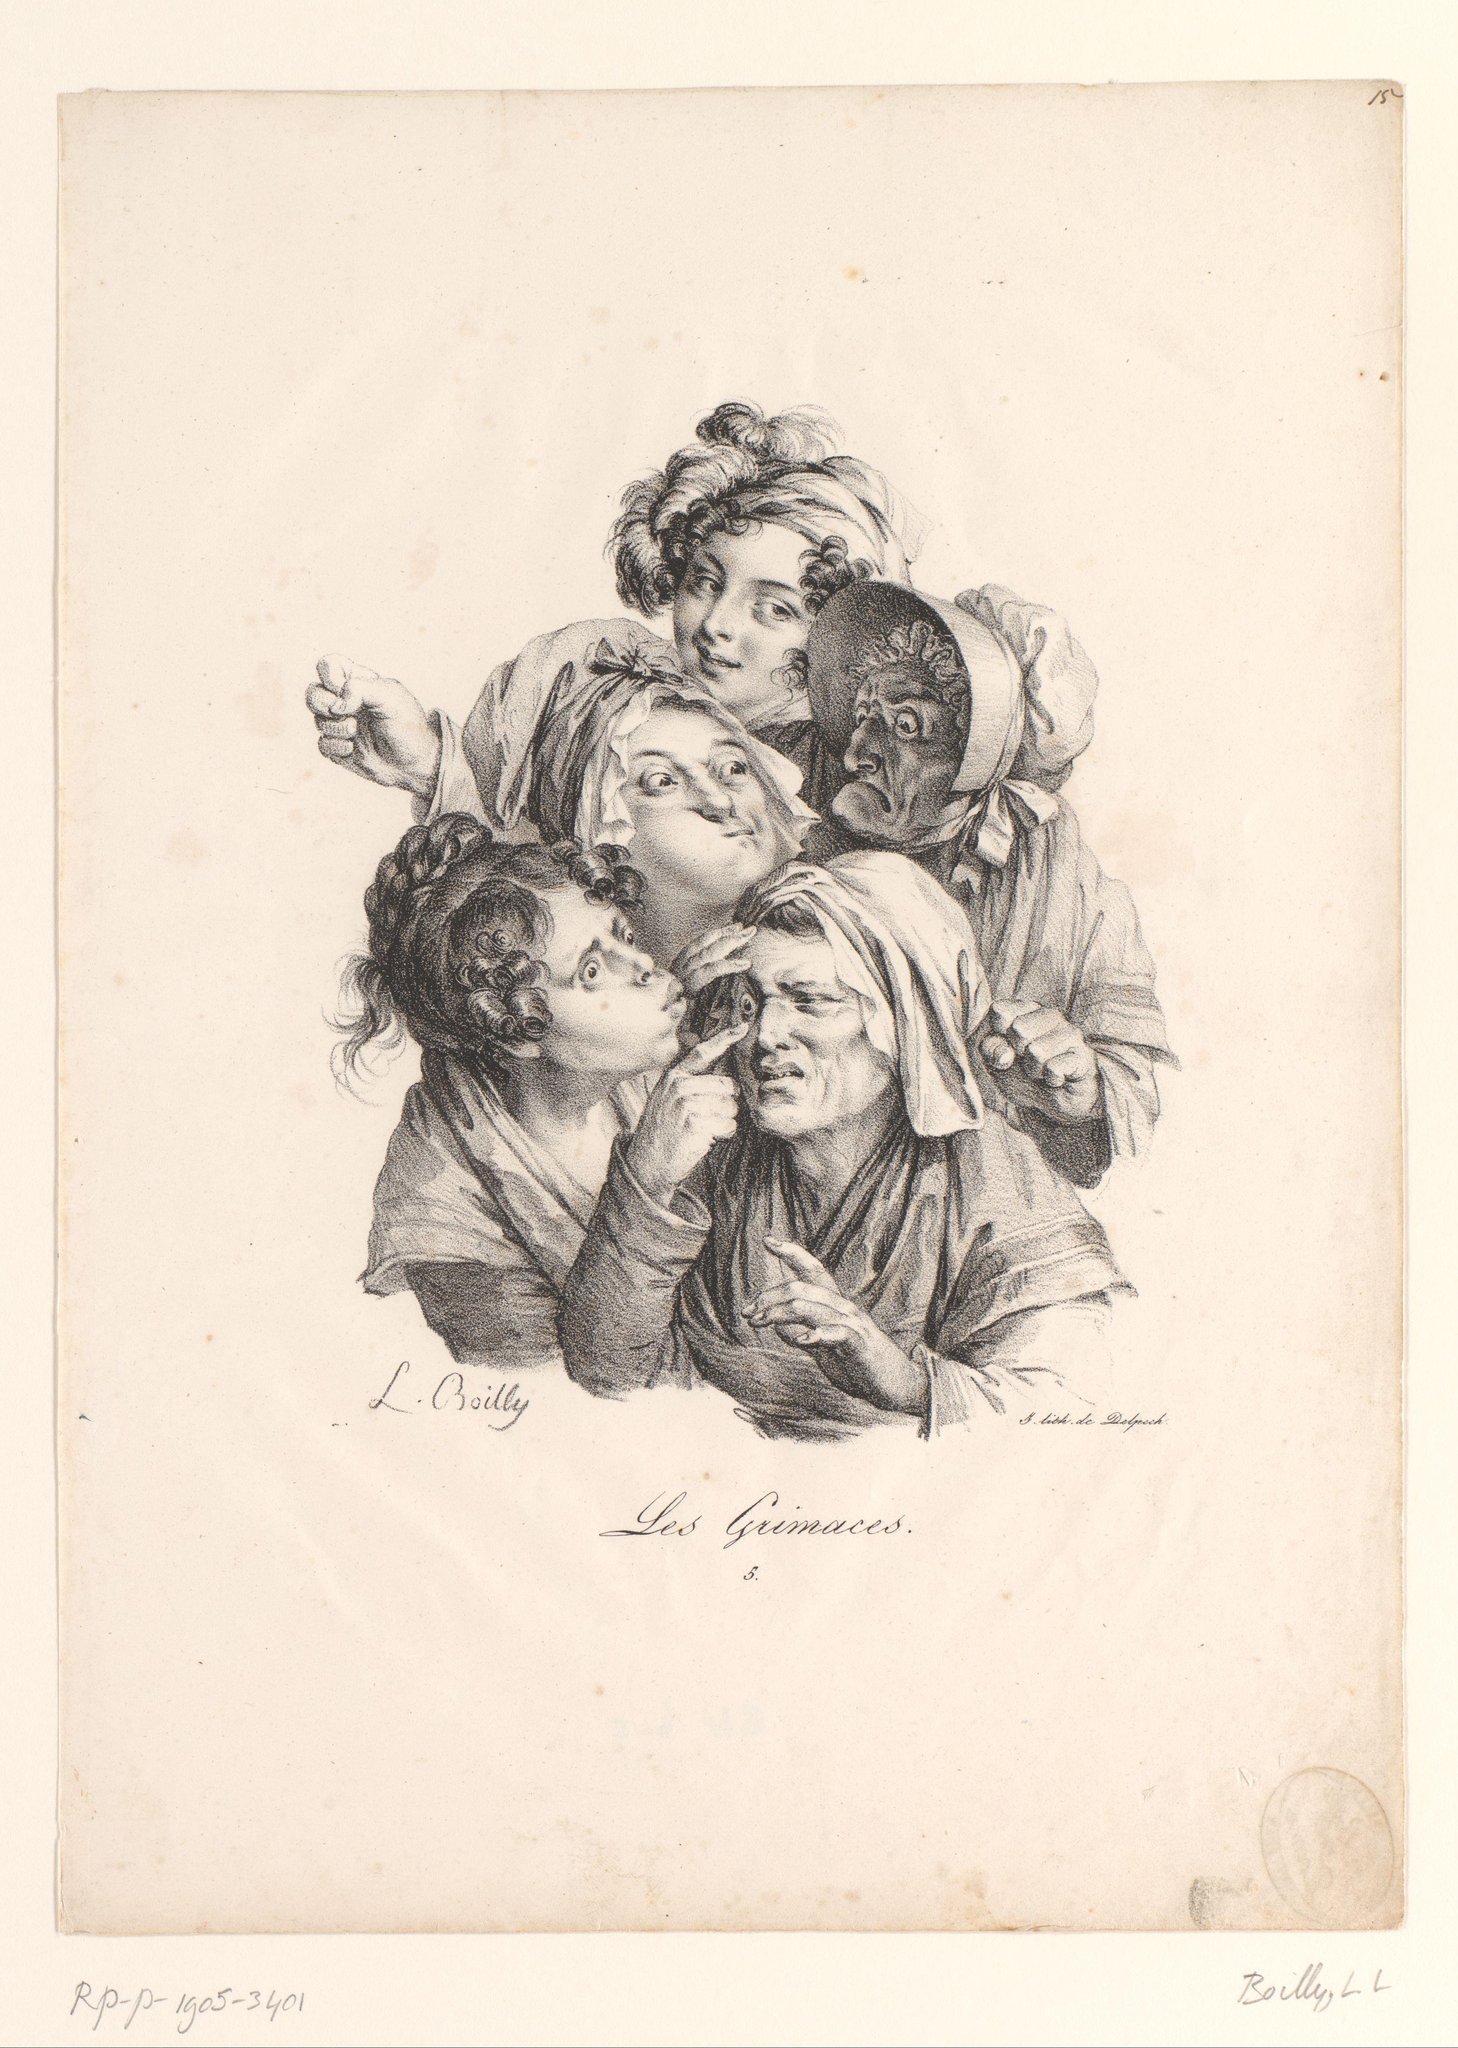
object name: cartoon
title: Gezichten met een grimas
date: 1823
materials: paper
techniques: lithograph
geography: paris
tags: caricatures (human types), morphology of facial expression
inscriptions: number: ‘15’, collector's mark: Lugt 2228a, stamp: ‘F. Buffa en Zoonen, Amsterdam, Kalverstraat no. 221’